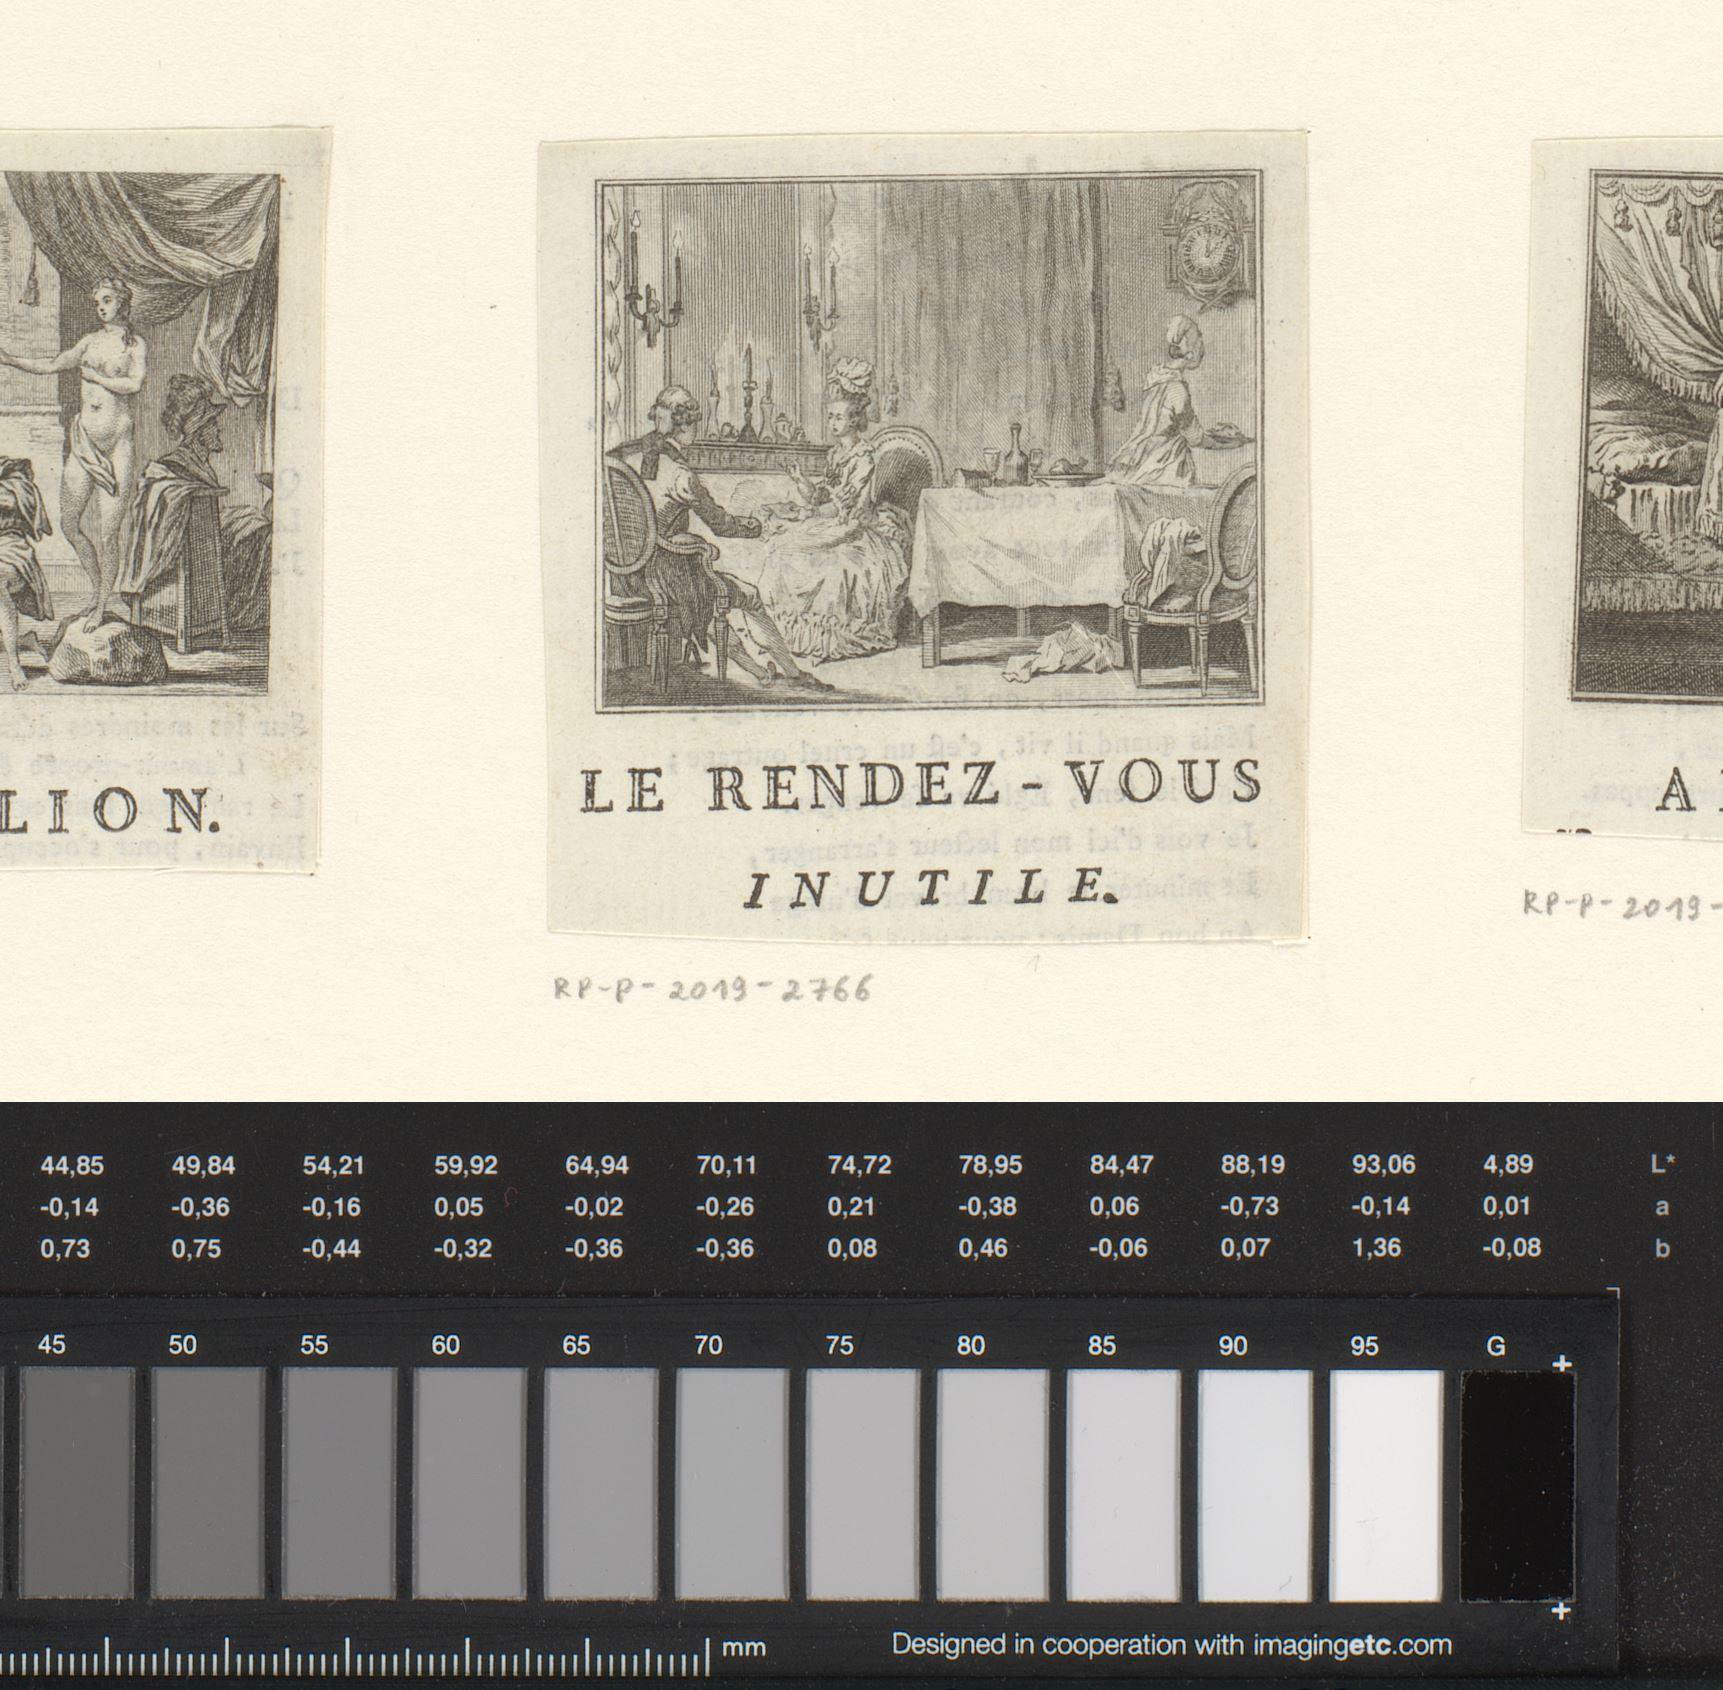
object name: print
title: Le rendez-vous inutile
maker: Anonymous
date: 1763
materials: paper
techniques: engraving, etching, letterpress printing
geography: france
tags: open hearth, fire-place, conversation, dialogue; conversation piece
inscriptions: collector's mark: Lugt 2228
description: Mogelijk prent uit: Grecourt, Jean Baptiste Joseph Willart de. Oeuvres diverses de M. de Grécourt, nouvelle édition, augmentée d'un grand nombre de pièces, revus sur les originales et du Philotanis. Amsterdam: s.n., 1763.